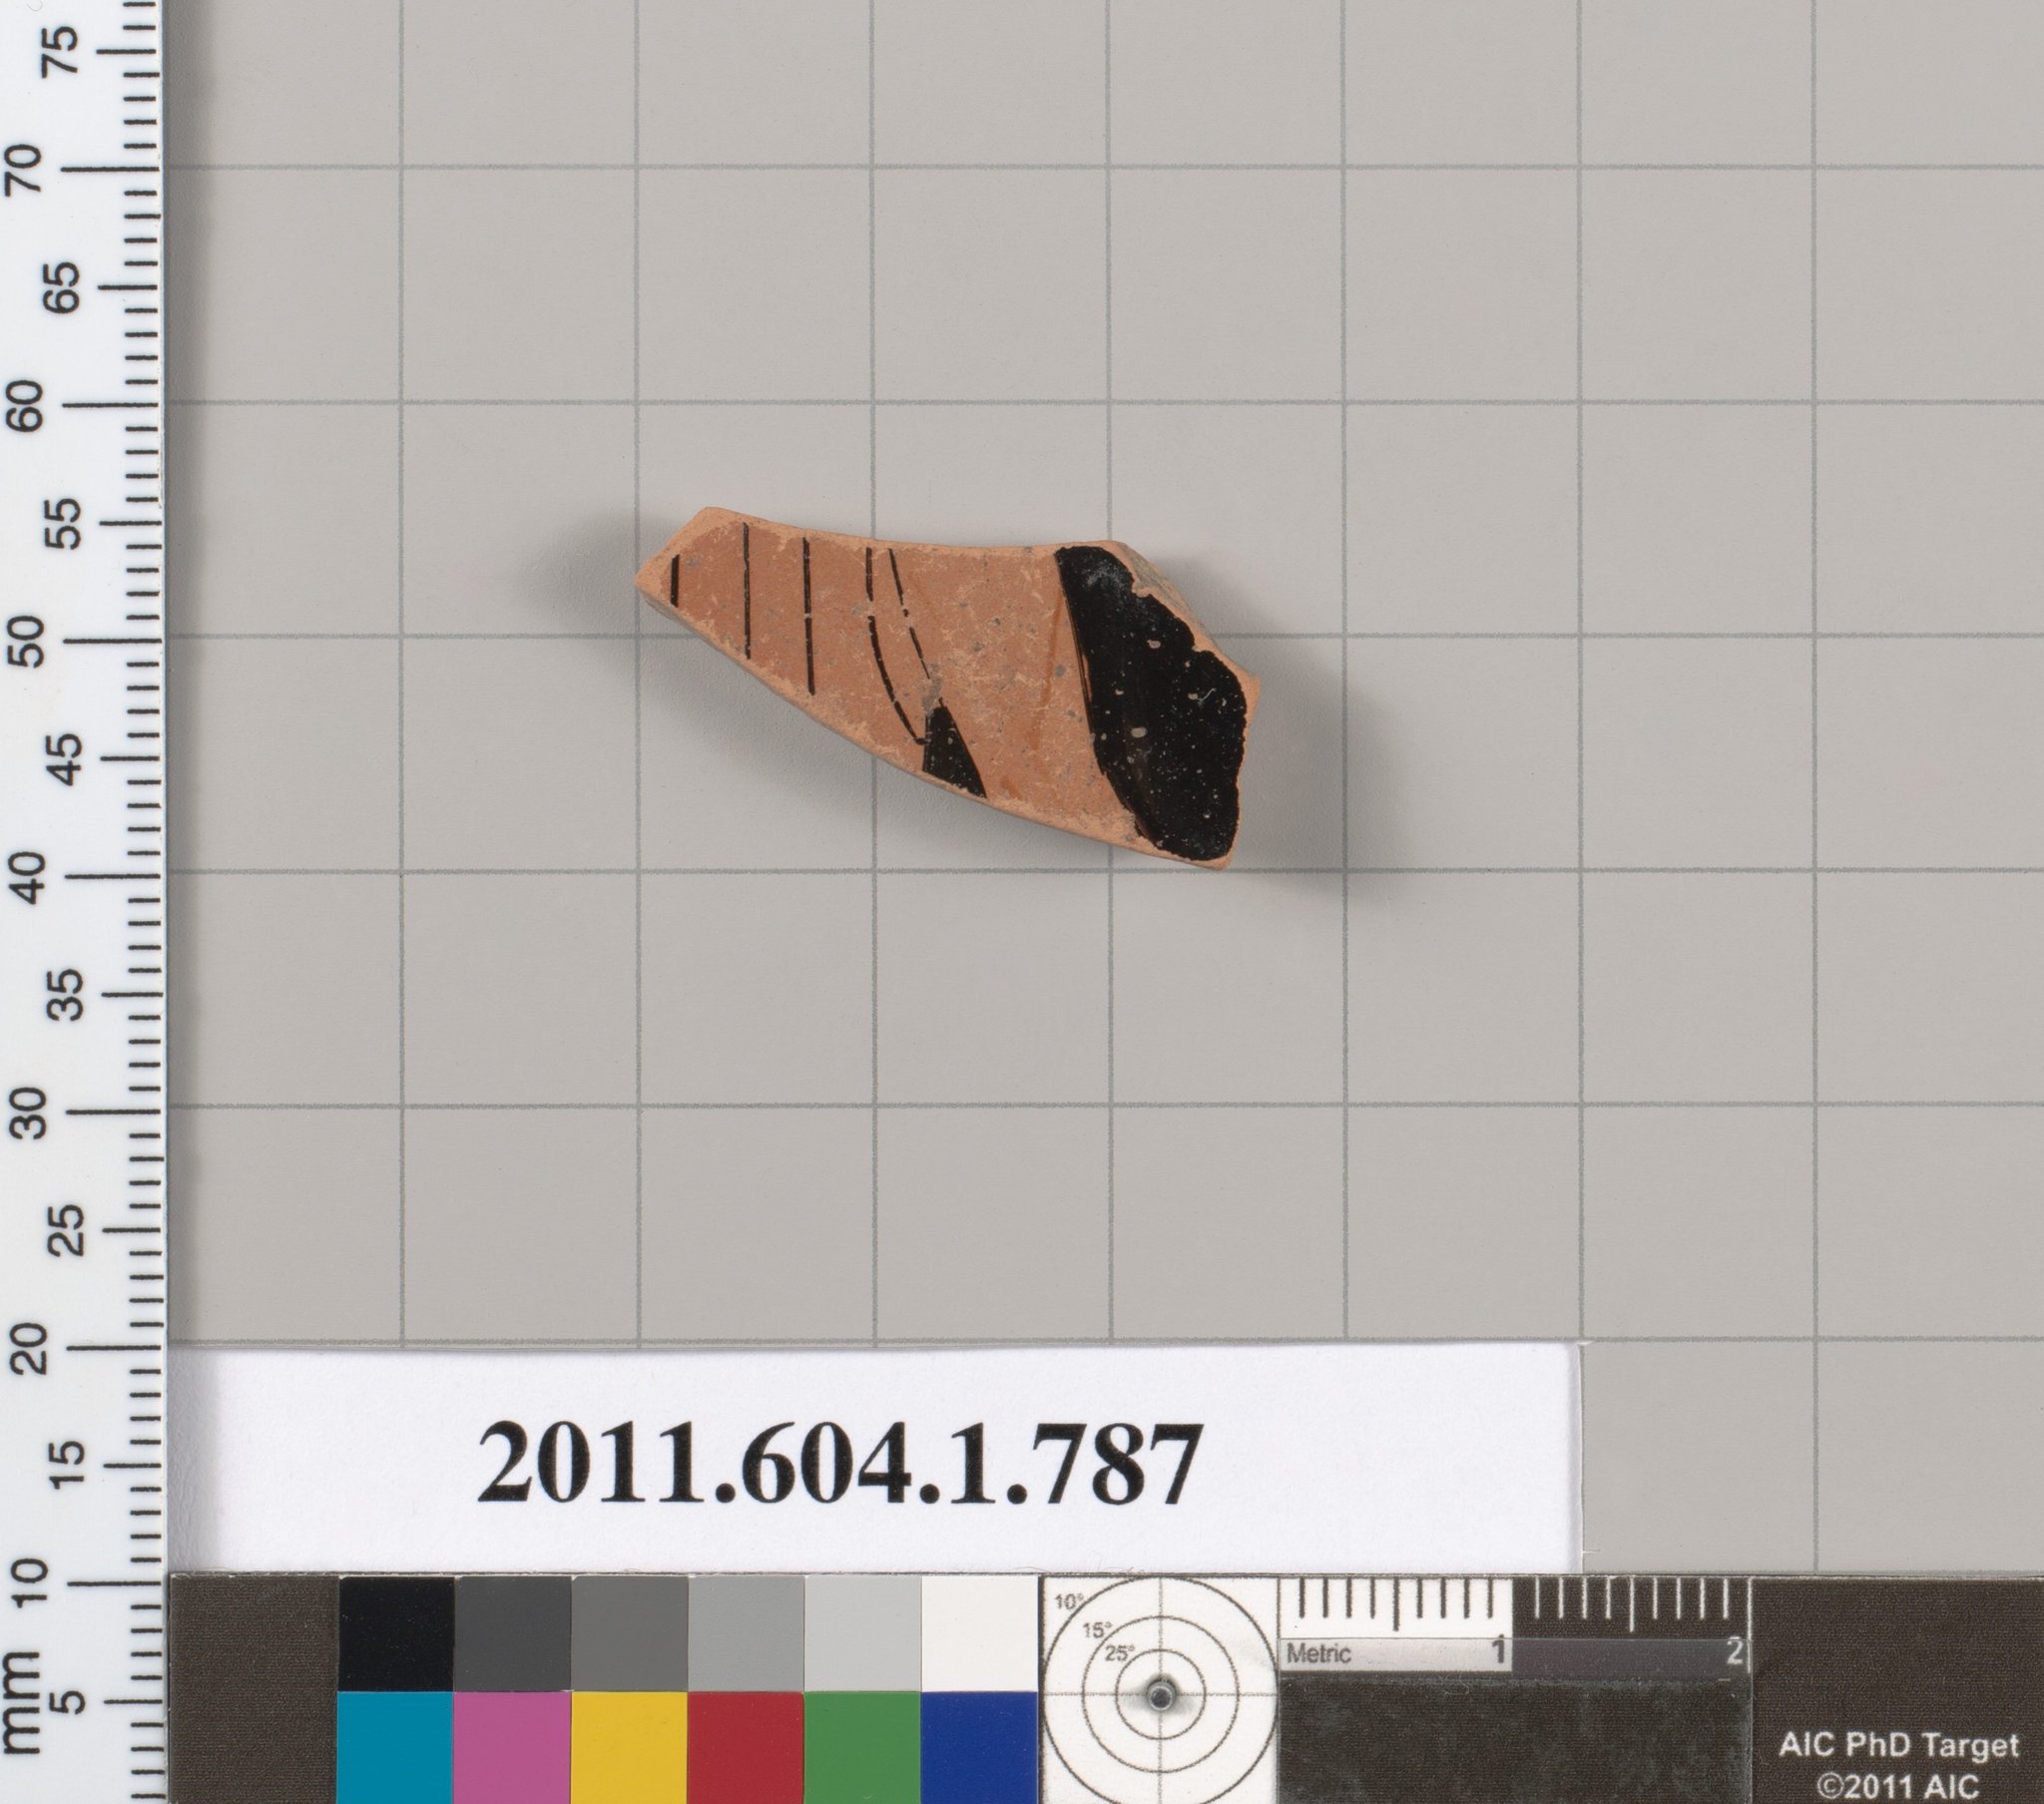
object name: kylix fragment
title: Terracotta fragment of a kylix (drinking cup)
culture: greek, attic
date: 475-451 BCE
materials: terracotta